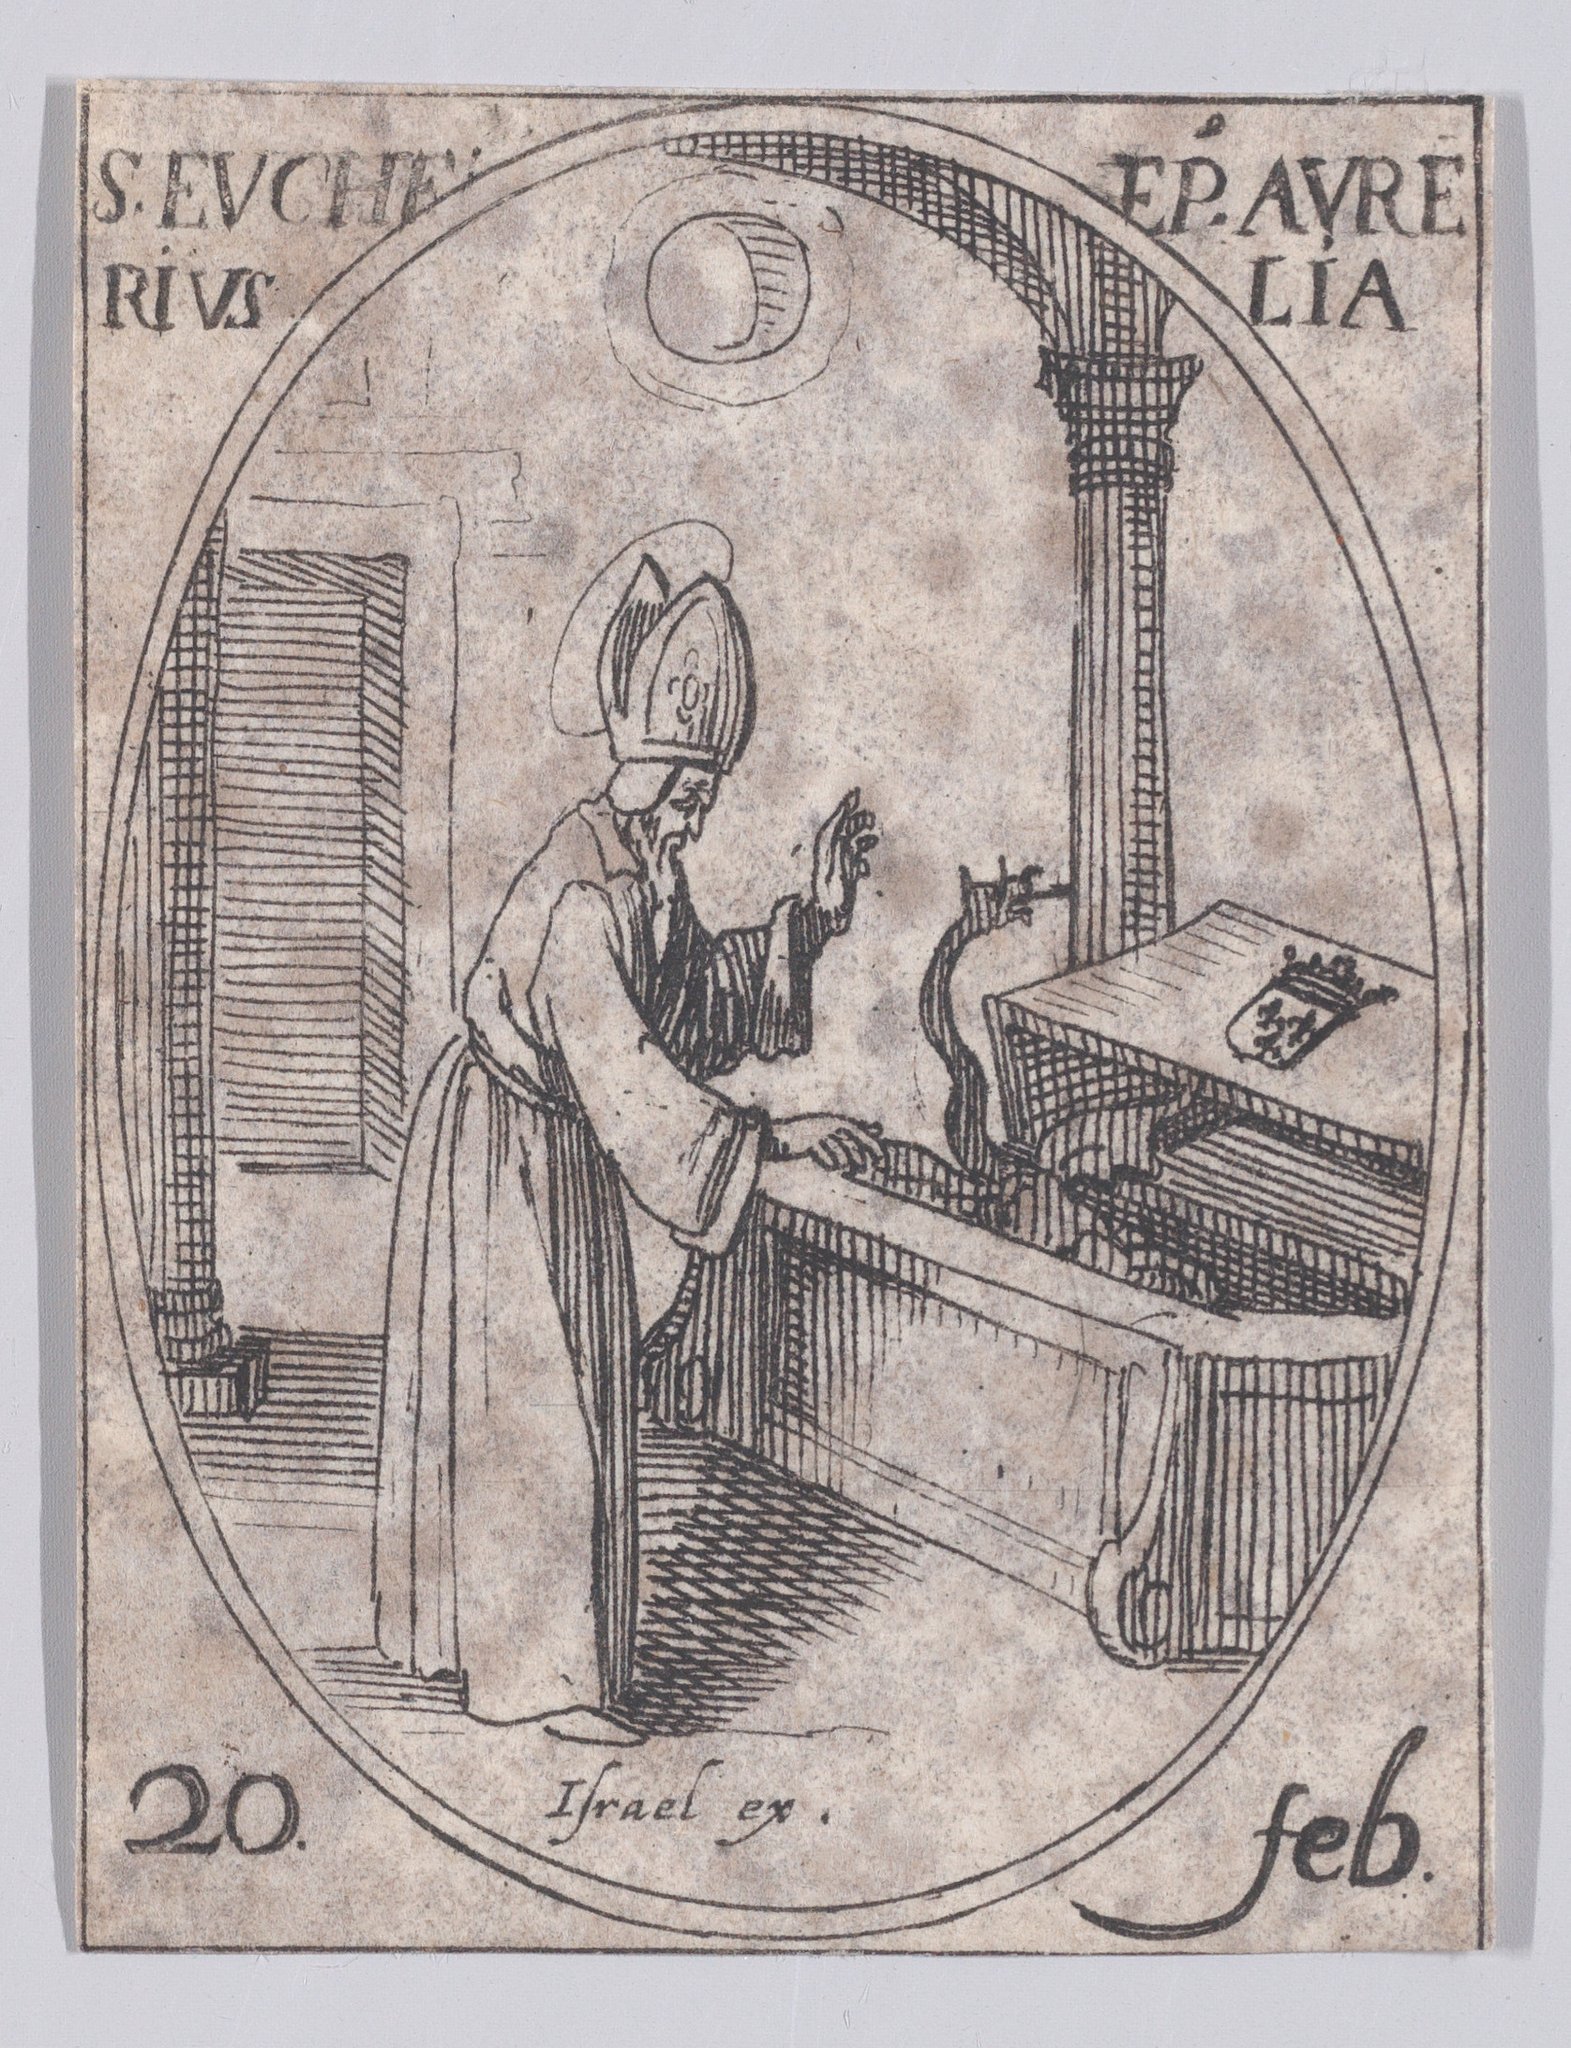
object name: print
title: S. Eucher, évêque d'Orléans (St. Eucherius, Bishop of Orleans), February 20th, from "Les Images De Tous Les Saincts et Saintes de L'Année" (Images of All of the Saints and Religious Events of the Year)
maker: jacques callot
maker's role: artist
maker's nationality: french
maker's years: 1592-1635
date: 1636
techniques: etching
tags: men,saints